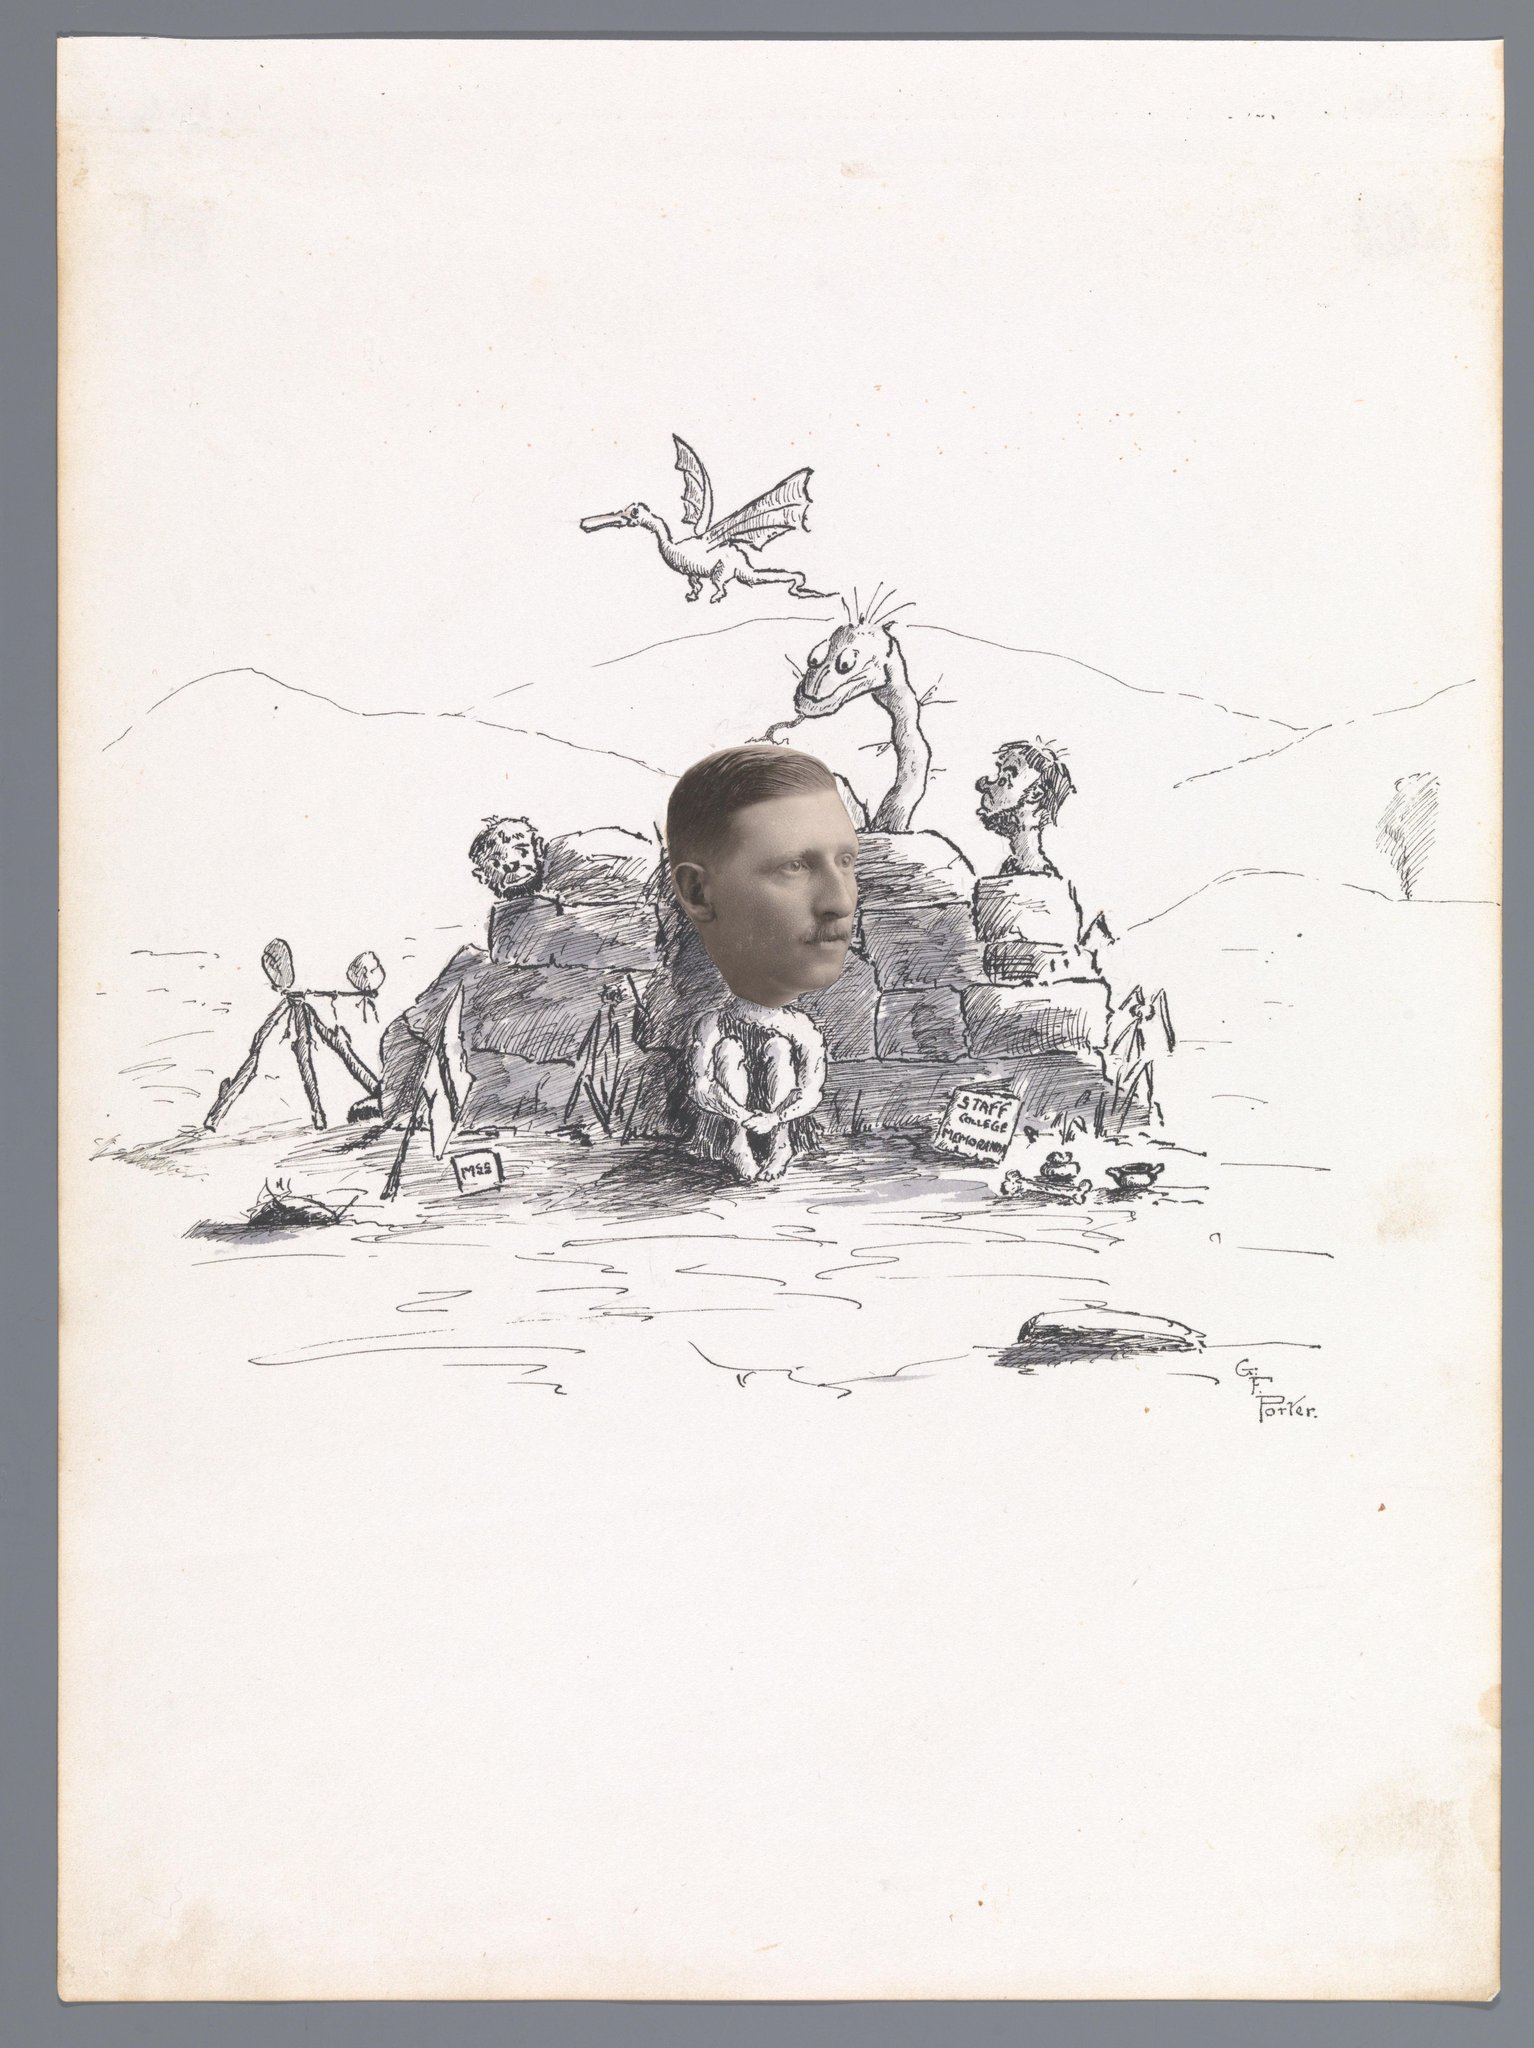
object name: drawing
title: Portret van een onbekende man als prehistorische mens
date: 1899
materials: paper, ink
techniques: brush, gelatin silver print, pen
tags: prehistoric man, anonymous historical person portrayed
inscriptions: inscription: ‘Staff/ collage/ memorandia’